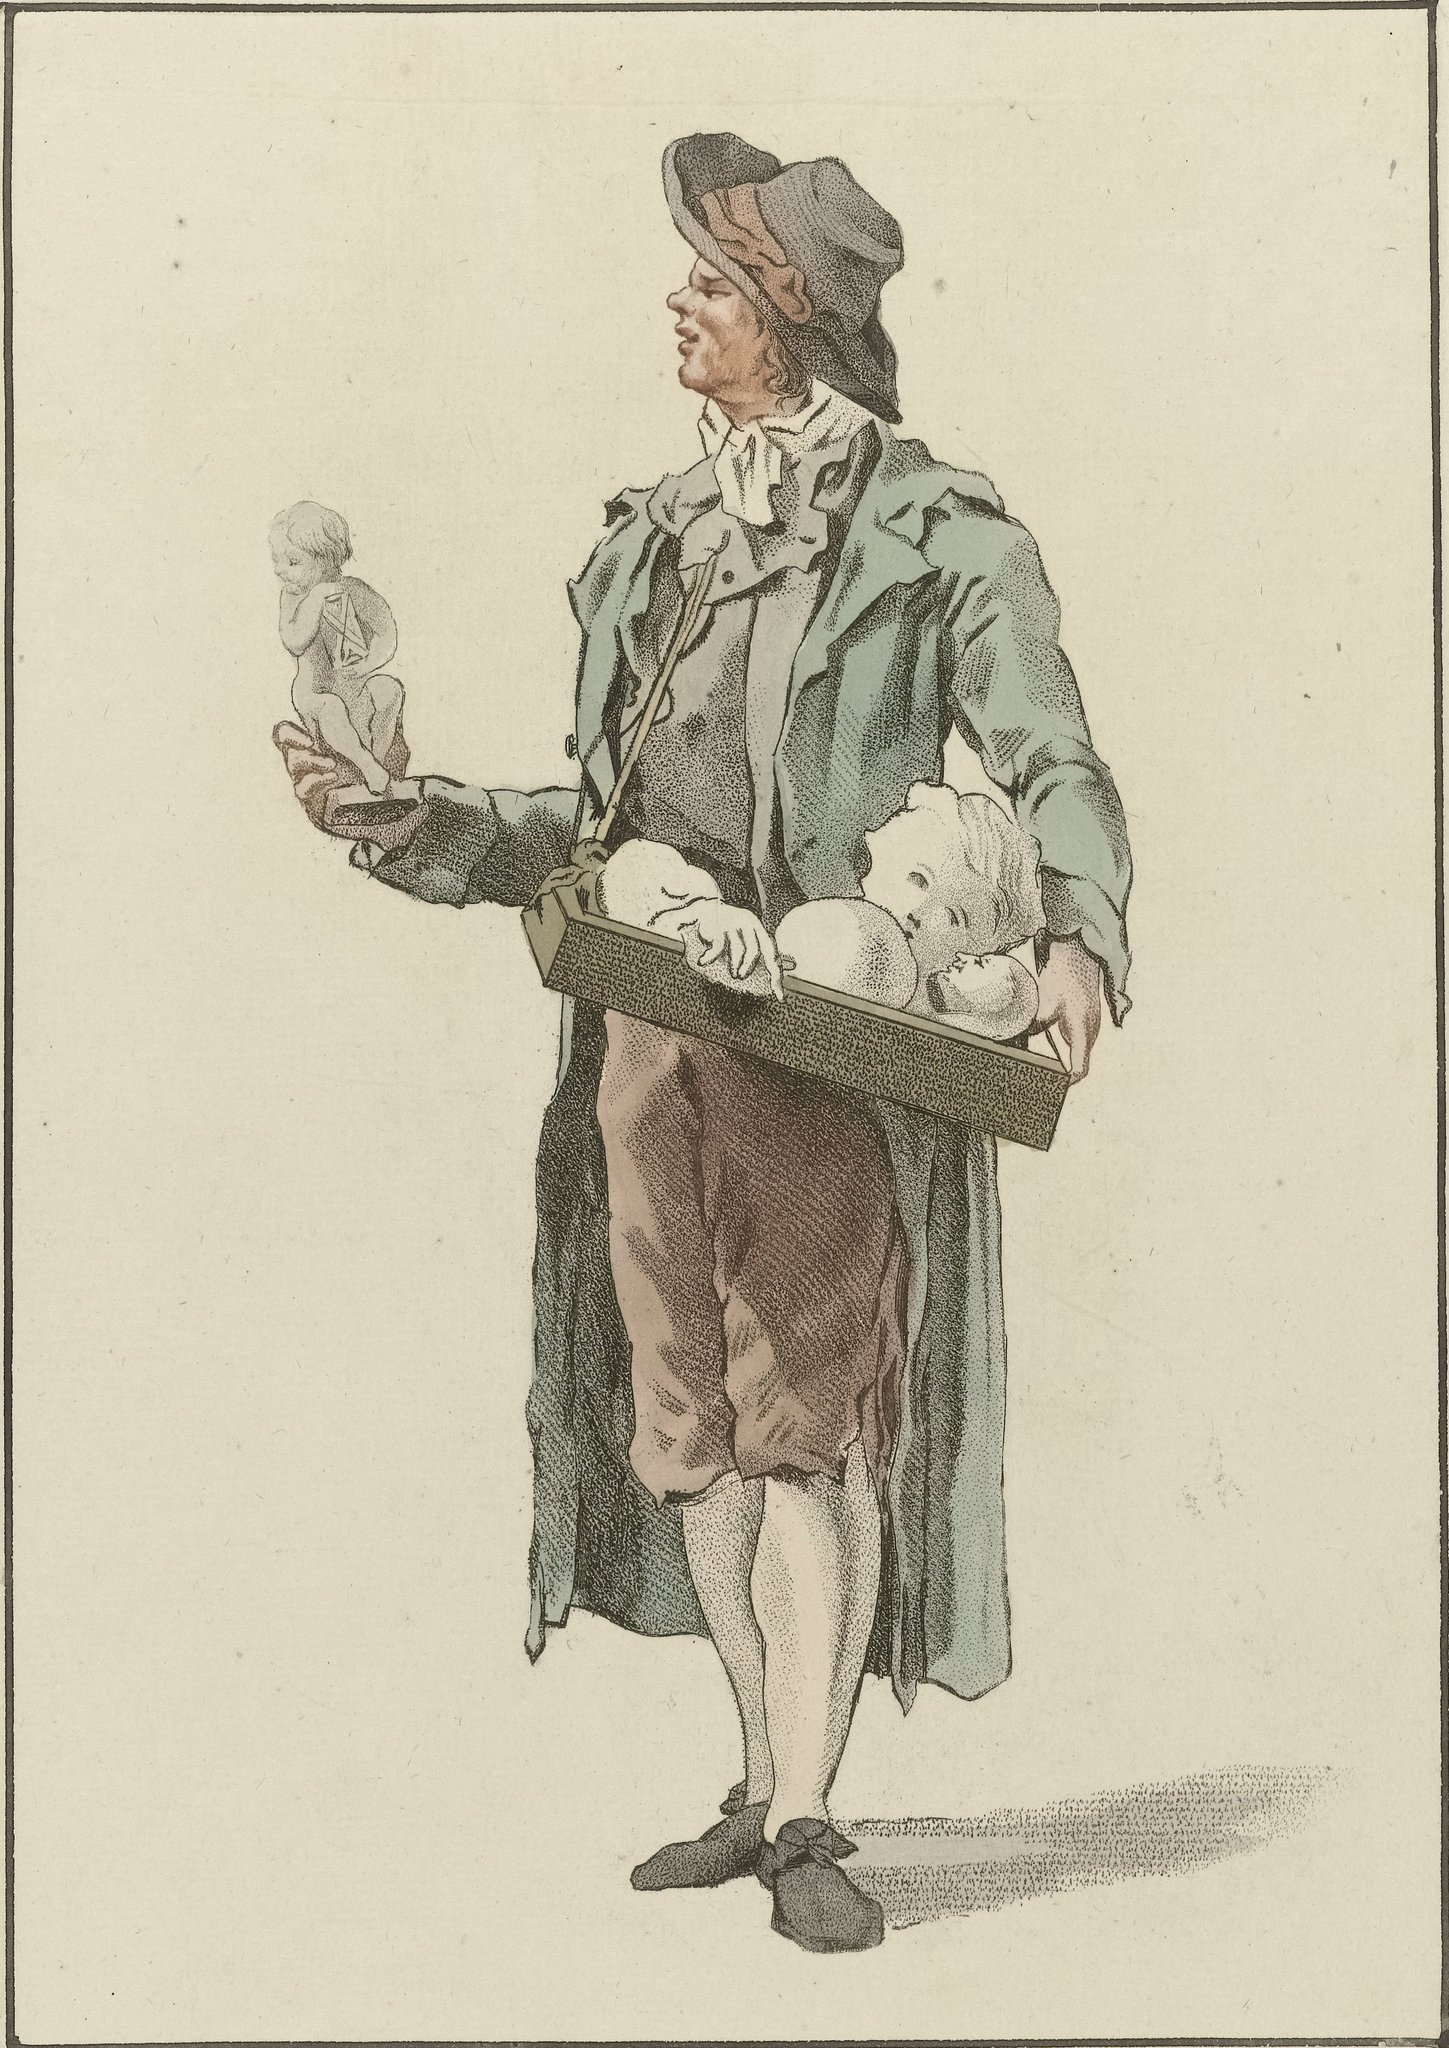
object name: print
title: Straatventer met gipsbeeldjes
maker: mathias de sallieth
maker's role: print maker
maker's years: 1749-1791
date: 1772-1791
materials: paper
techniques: printmaking, etching, hand coloring, lithography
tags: street-trader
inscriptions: collector's mark: Lugt 2233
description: De prent verscheen vanaf 1818 tevens als onderdeel van een 33-delige reeks prenten door Mathias de Sallieth, samengebonden in: Perkois, Jacobus, Prins, Johannes Huibert. Verzameling van verschillende gekleede mans- en vrouwenstanden, ter oefening van jonge schilders en liefhebbers. Rotterdam: Johannes Immerzeel, 1818.